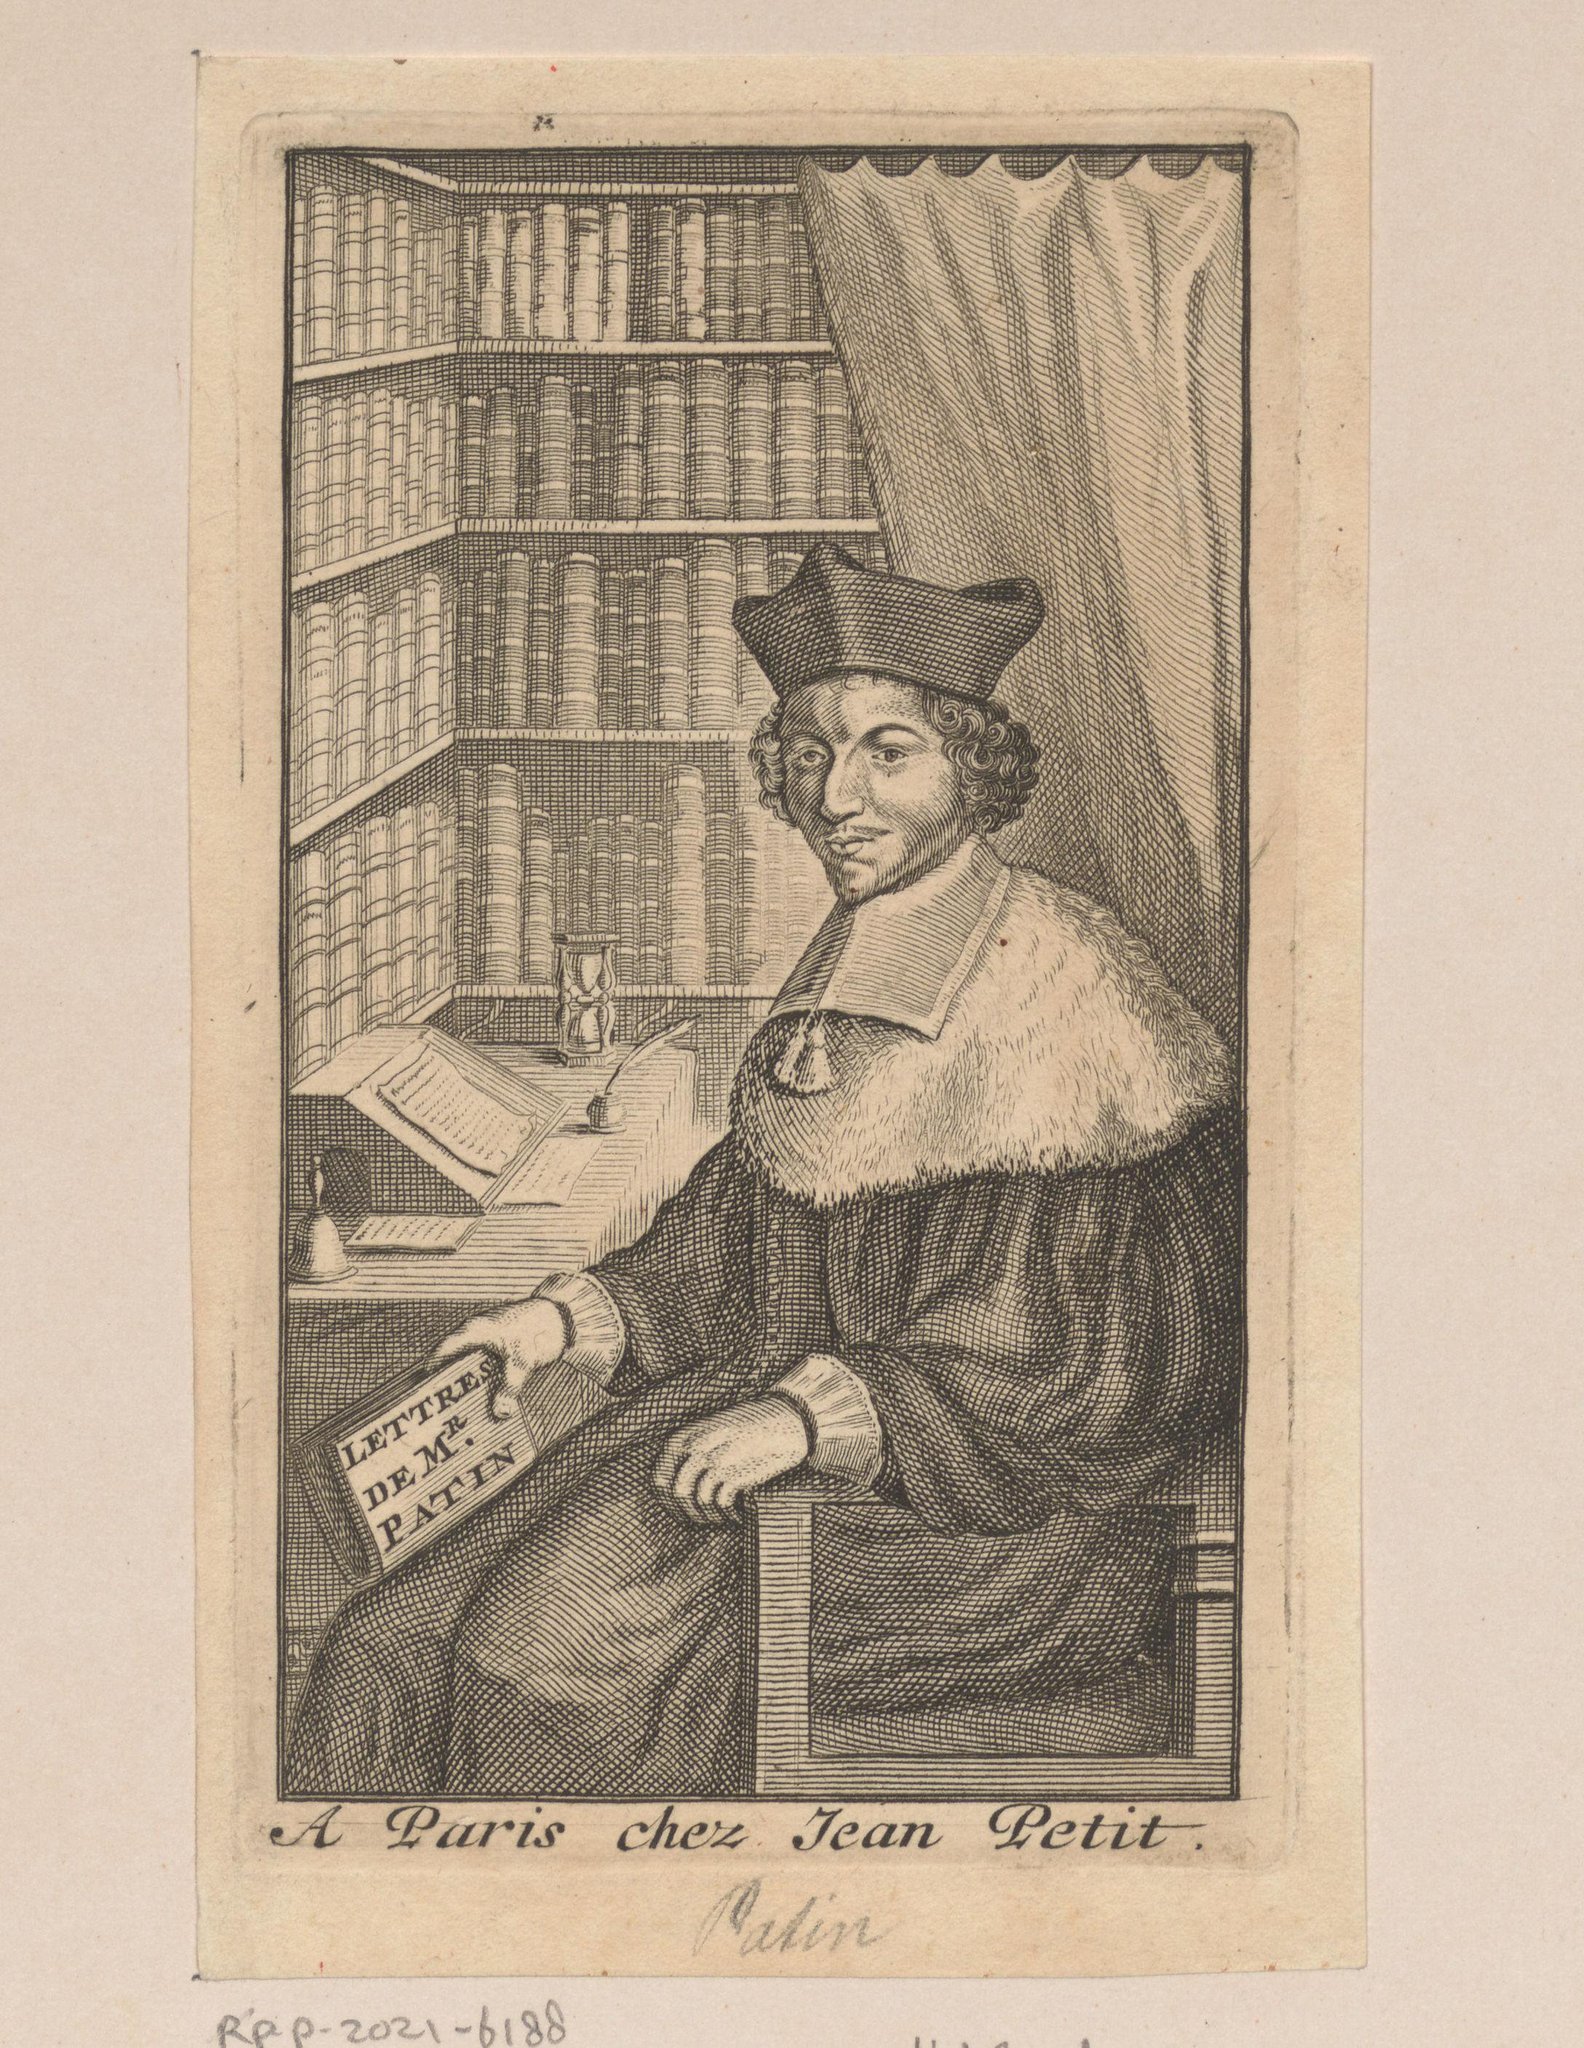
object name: print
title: Portret van Guy Patin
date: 1692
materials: paper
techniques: engraving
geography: paris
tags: paris, adult man, historical persons, physician, doctor, study; 'studiolo'; library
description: Titelpagina voor: Patin, Guy. Lettres choisies de feu M. Guy Patin (...). 2 dln. Parijs: Jehan Petit, 1692, dl. 1.